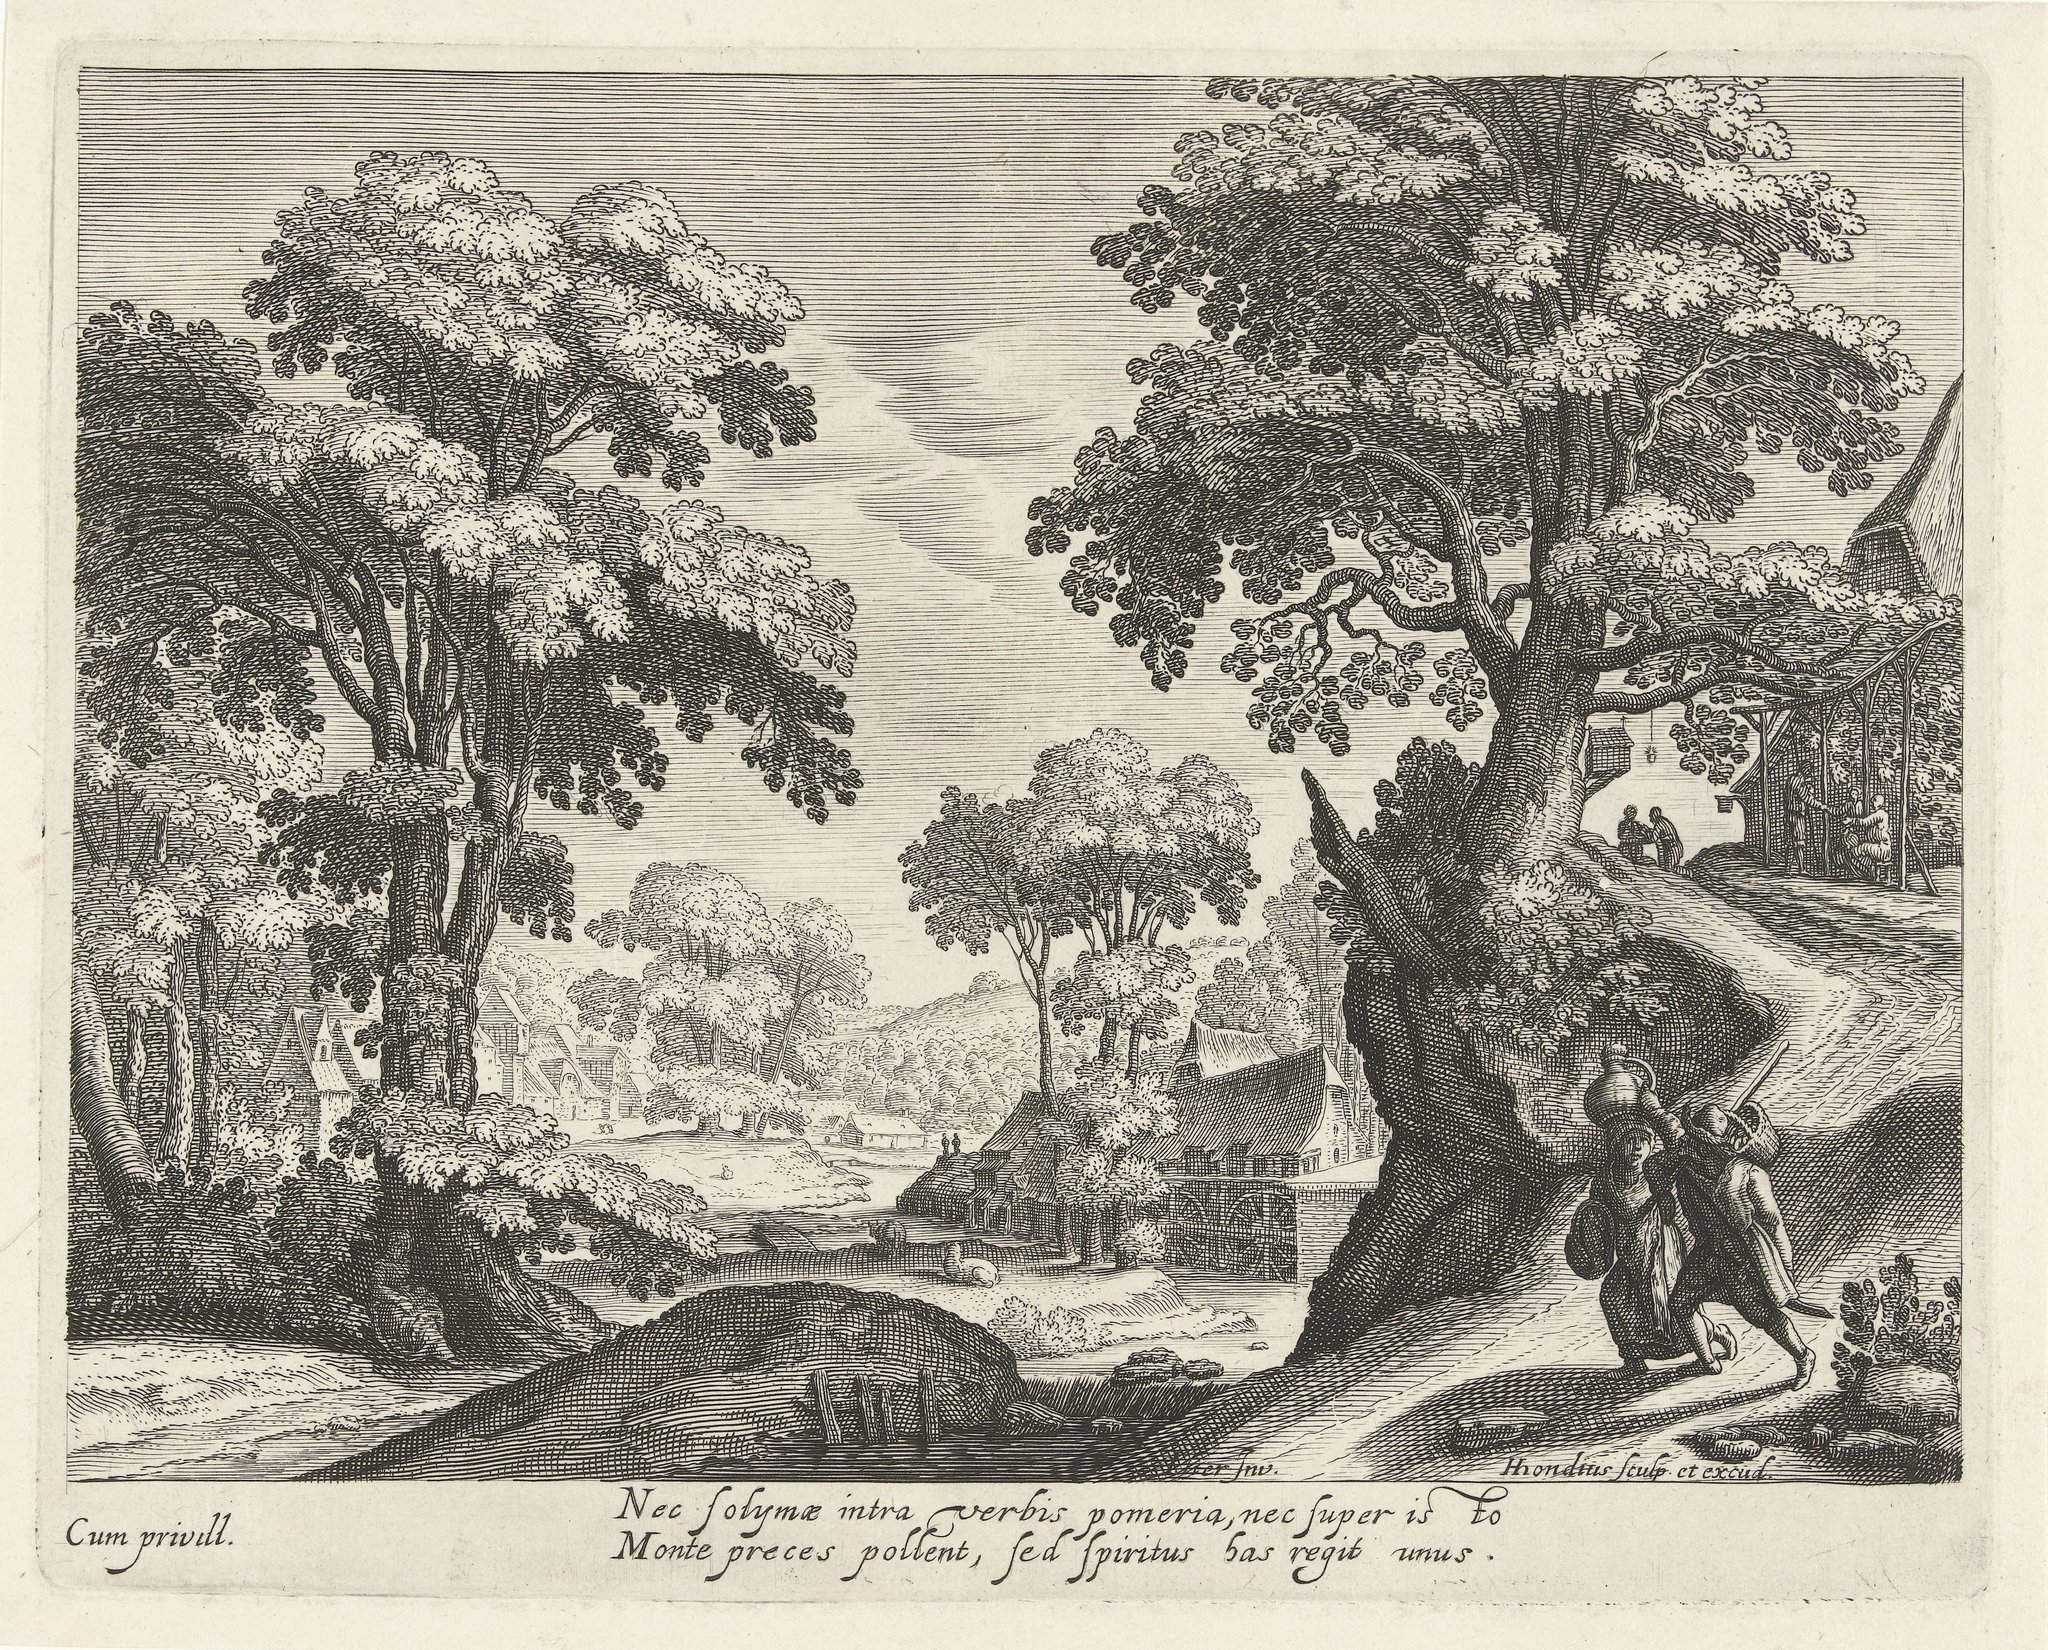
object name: print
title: Landschap met een boerenpaar op een landweg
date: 1599-1649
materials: paper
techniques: engraving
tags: farmers, watermill in landscape, landscapes (+ landscape with figures, staffage), carrying something on the head or on the shoulders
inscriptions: collector's mark: Lugt 2228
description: Boomrijk landschap met op de voorgrond een boerenpaar op een landweg en op de achtergrond een paar huizen, waaronder een boerderij met een watermolen. Op de kronkelende landweg rechts nog enkele figuren en een vogelhuis aan een boom. De vrouw van het paar draagt een kruik op het hoofd, de man heeft een mand aan een stok over zijn schouder. Onder de voorstelling twee regels in het Latijn.